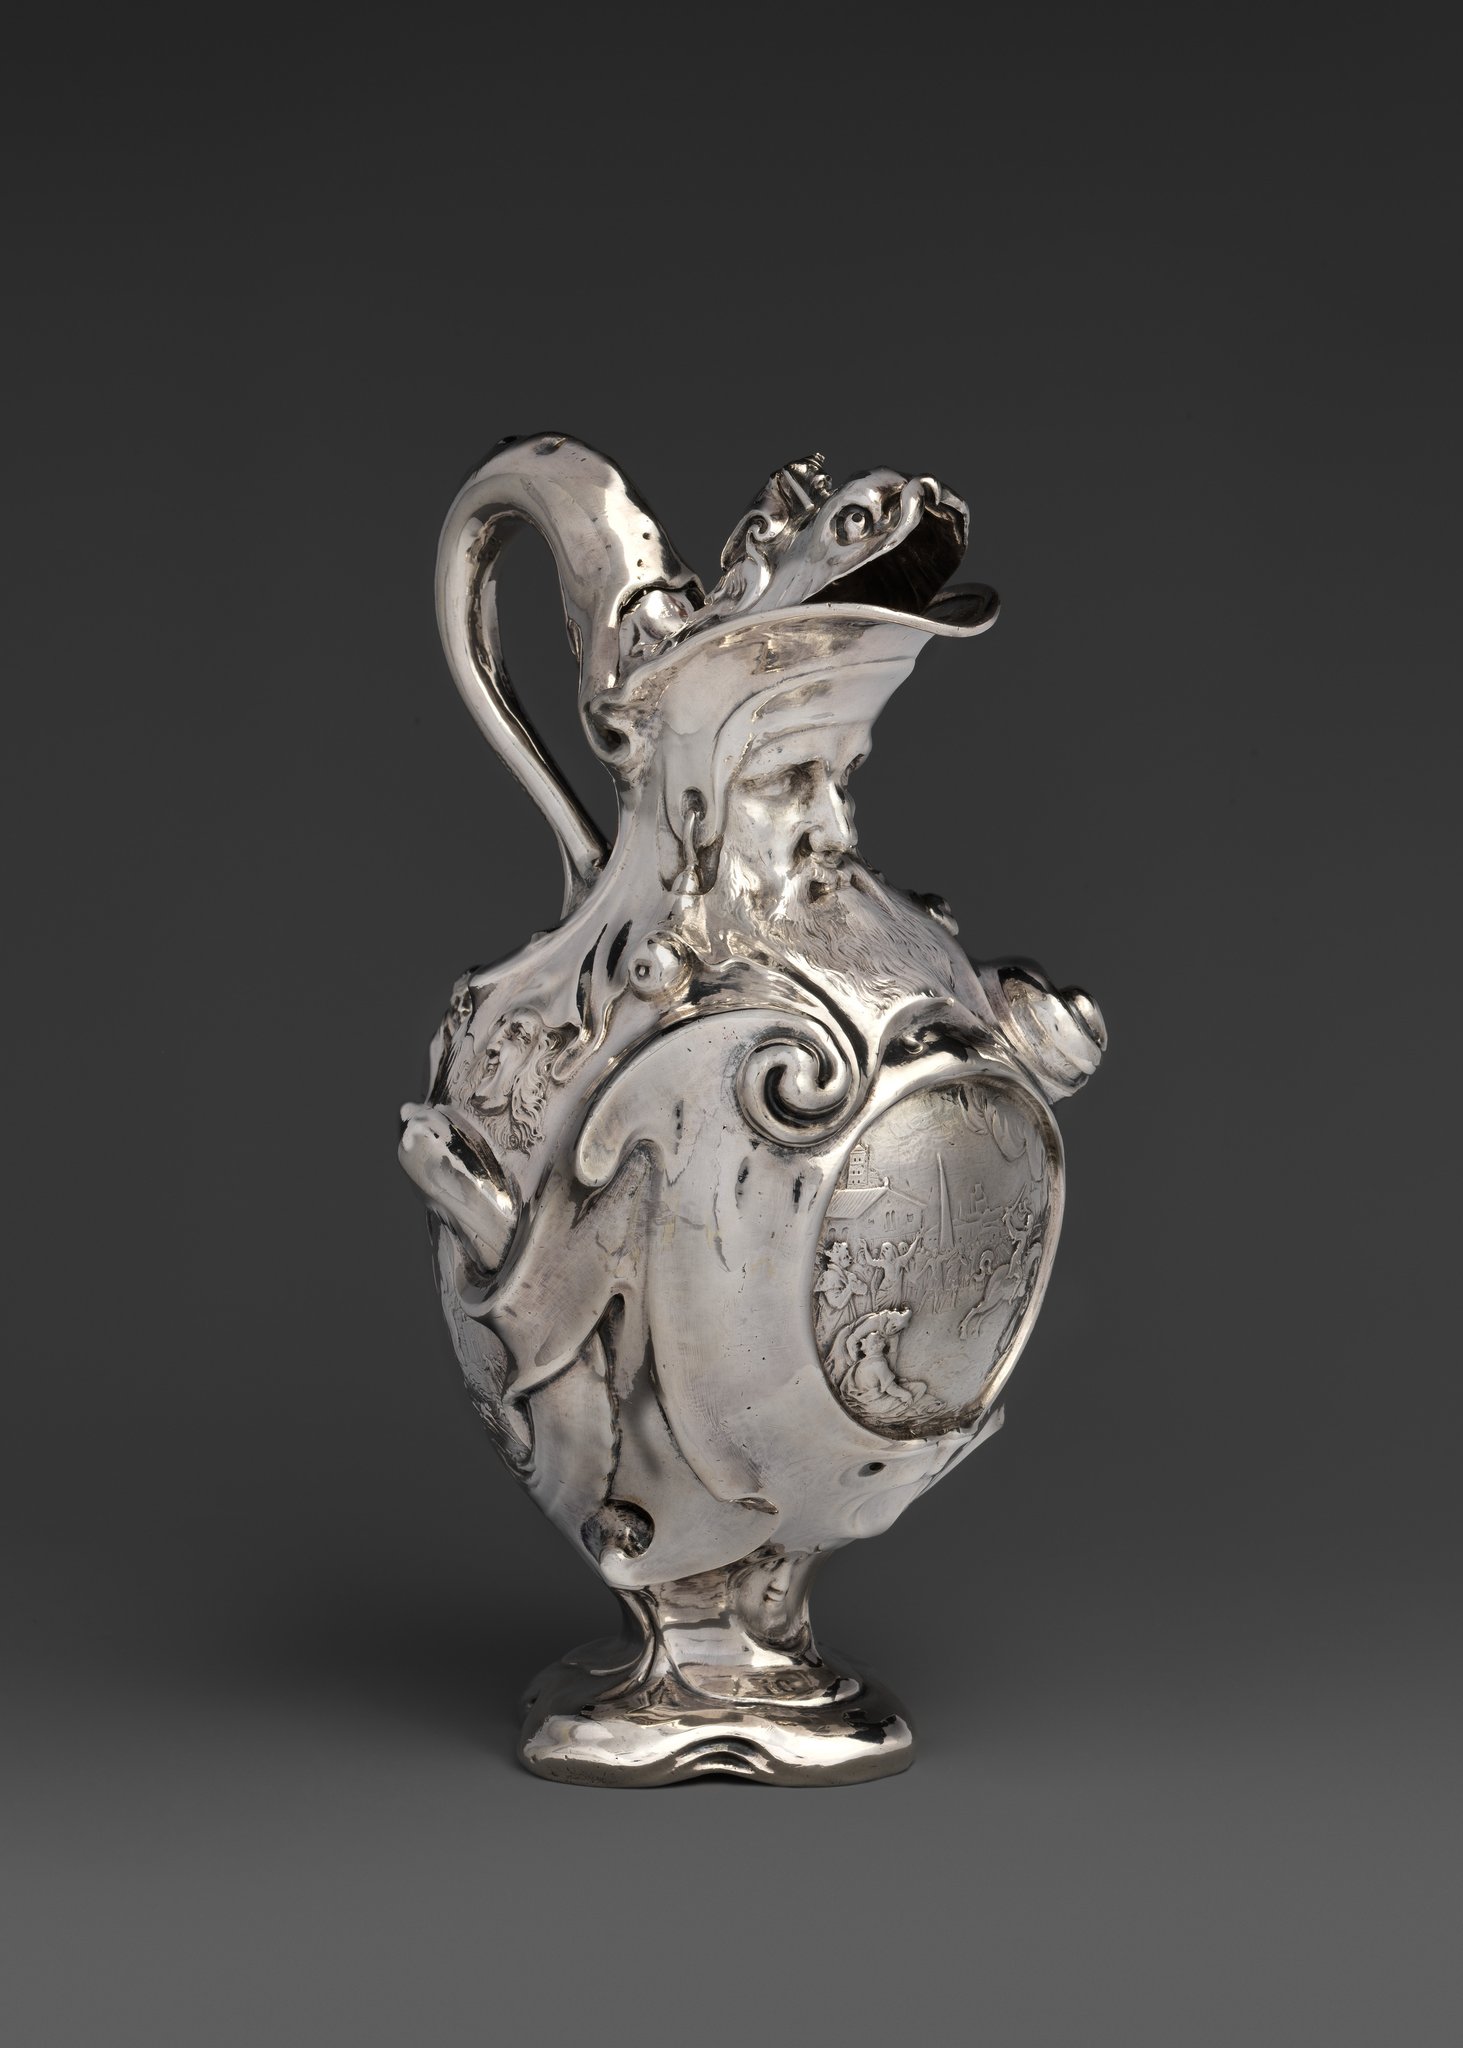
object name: ewer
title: Ewer with scenes depicting the legend of Marcus Curtius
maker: adam van vianen i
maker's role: maker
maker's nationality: netherlandish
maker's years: 1563-1627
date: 1619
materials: silver